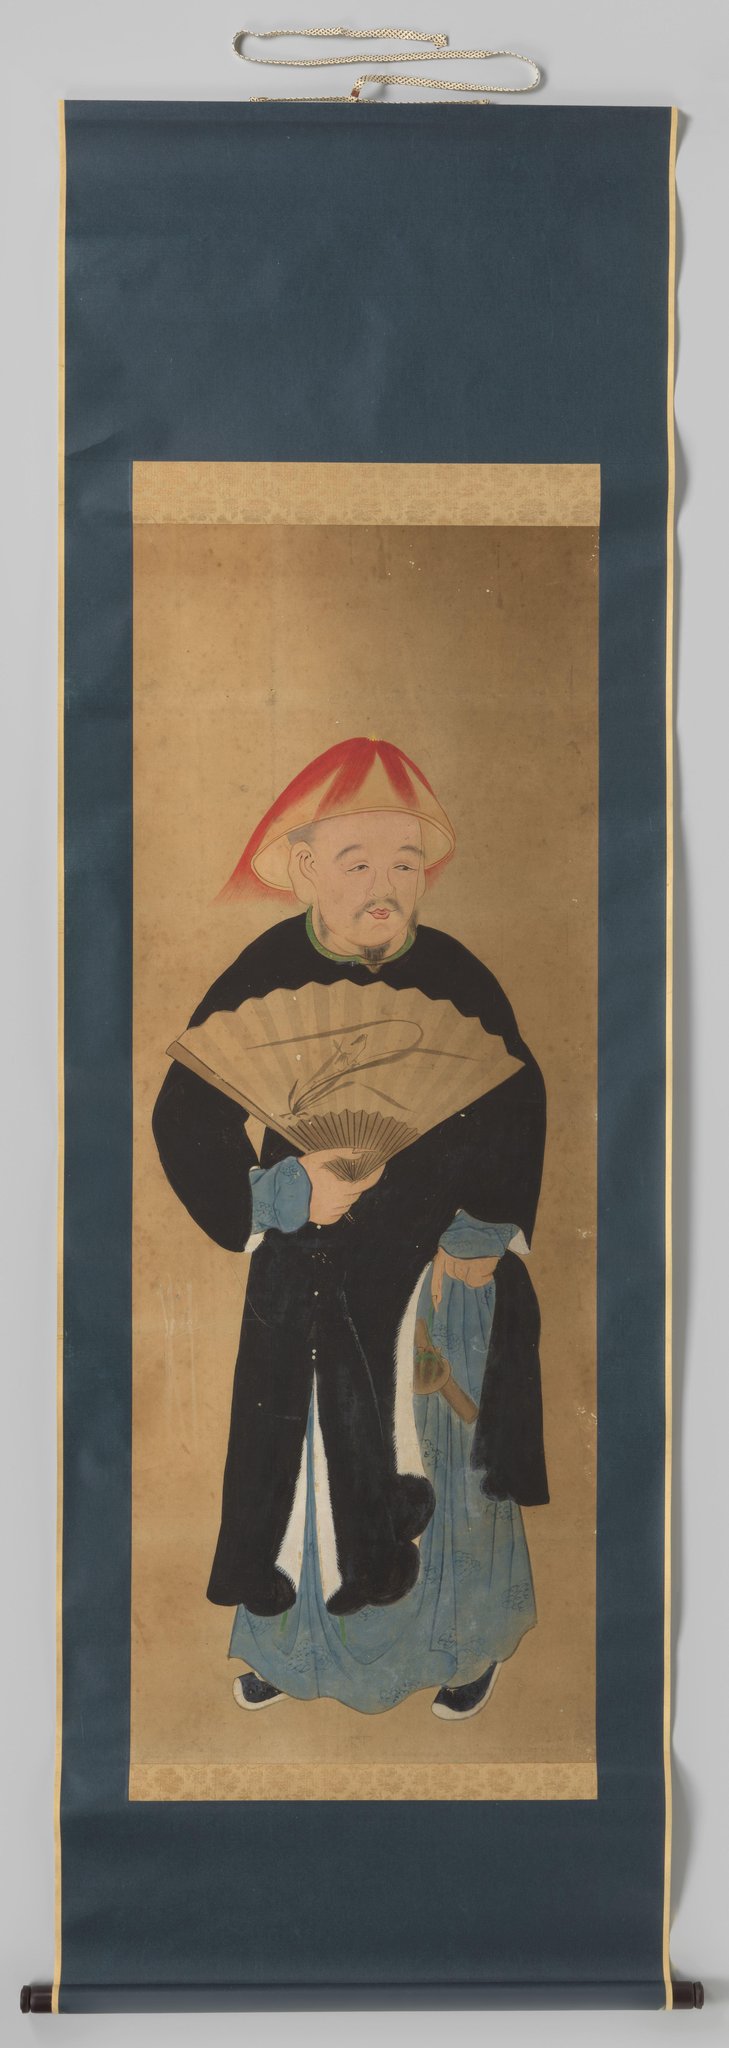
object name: kakemono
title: Chinese geletterde ambtenaar te Deshima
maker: Anonymous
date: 1800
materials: cardboard, paper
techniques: painted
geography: japan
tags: netherlands, china, japan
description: Portret van een Chinese waardigheidsbekleder en literaat met waaier uit de Chinese nederzetting te Deshima. De man draagt een zwarte mantel gevoerd met bont. In zijn rechterhand houdt hij een waaier beschilderd met een orchideeënplant. Kenmerkend voor de Chinese geletterde zijn ook de welverzordgde lange vingernagels. Terwijl hij met zijn linkerhand de mantel opzij schuift, wijst hij op zijn goedgevulde geldbuidel. Ook de rode pluim met de gele knop op zijn hoofddeksel wijst op een bepaalde ambtenaren rang. De rolschildering zit in een kartonnen doos met deksel.